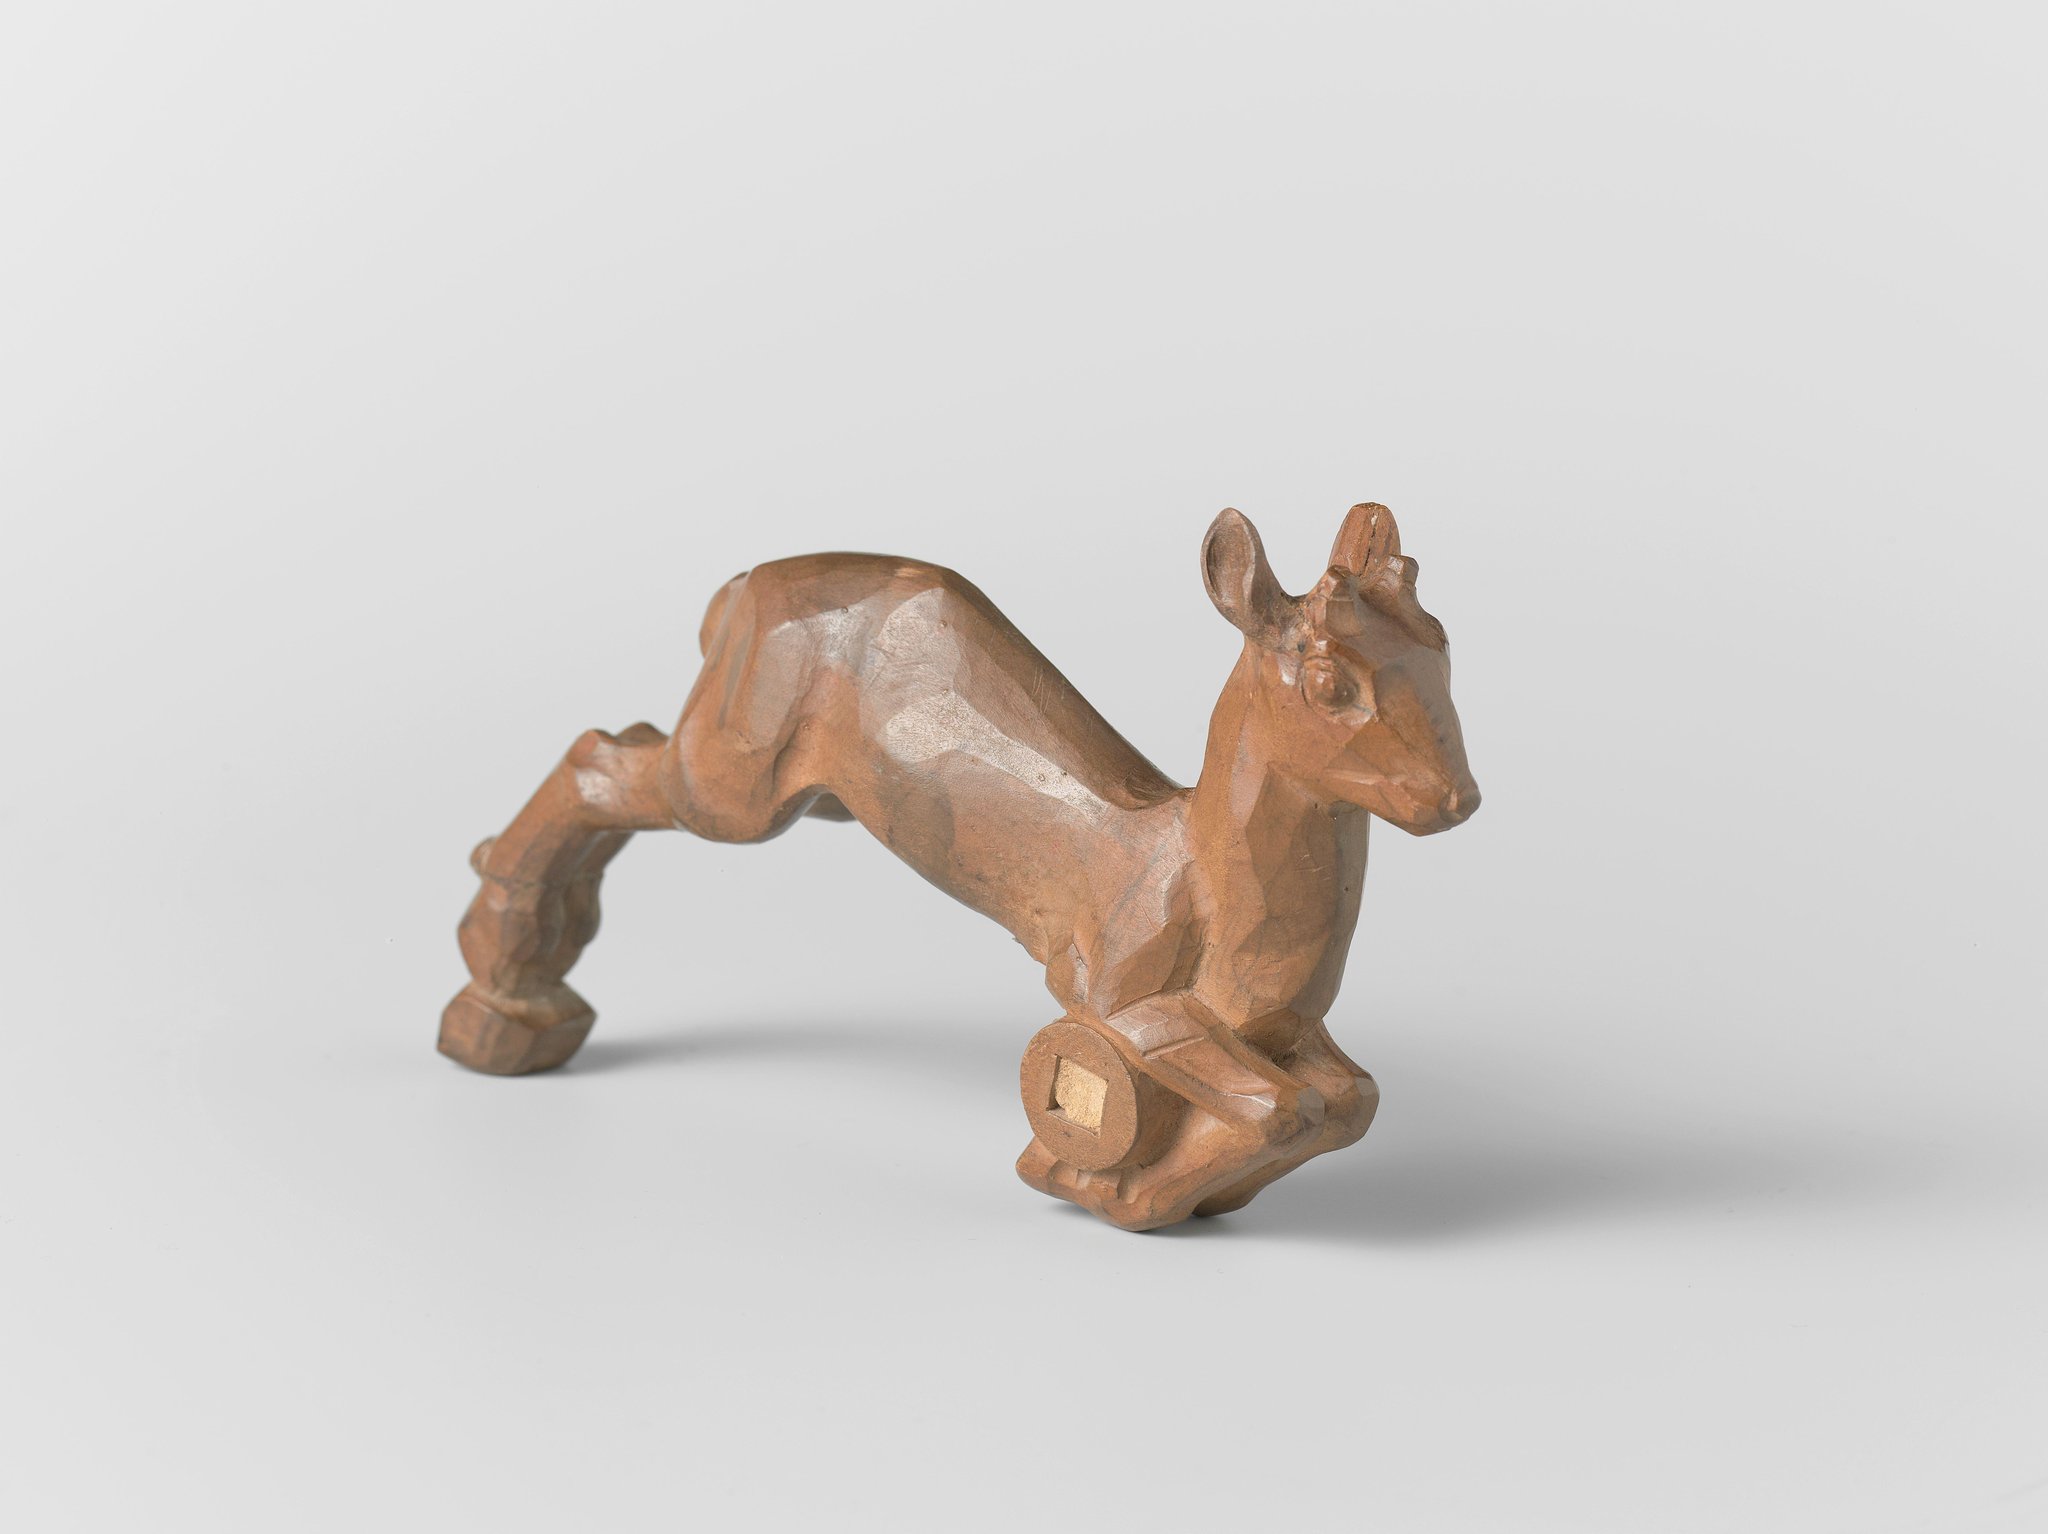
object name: bar handle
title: Deurklink in de vorm van een springende hinde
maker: lambertus zijl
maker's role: designer, draughtsman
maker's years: 1866-1947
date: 1900-1910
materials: wood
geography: netherlands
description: Model voor een deurklink van notenhout in de vorm van een springende hinde. Model van de deurklinken voor de interieurs van C.A. Lion Cachet voor het huis van Th. G. Dentz van Schaik, Frederiksplein 50 te Amsterdam.